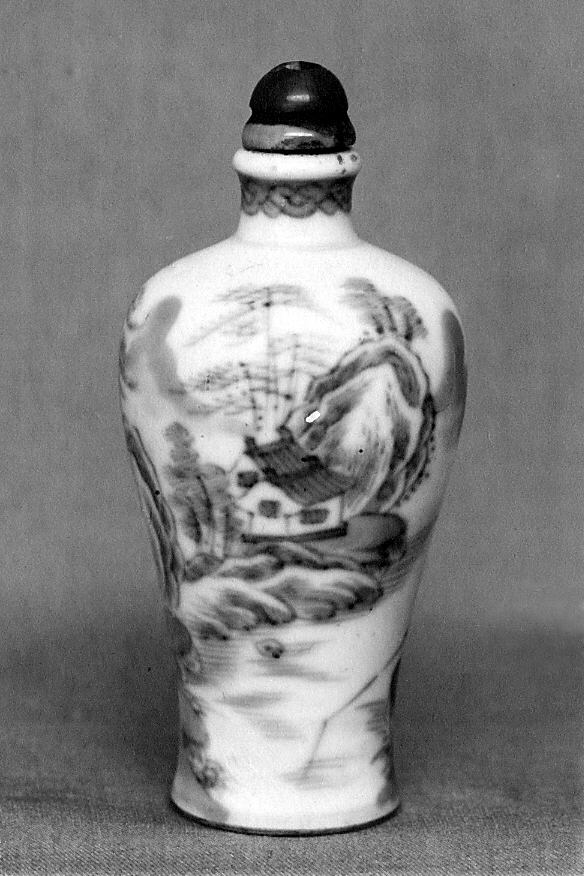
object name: snuff bottle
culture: chinese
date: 1801-1900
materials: porcelain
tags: houses